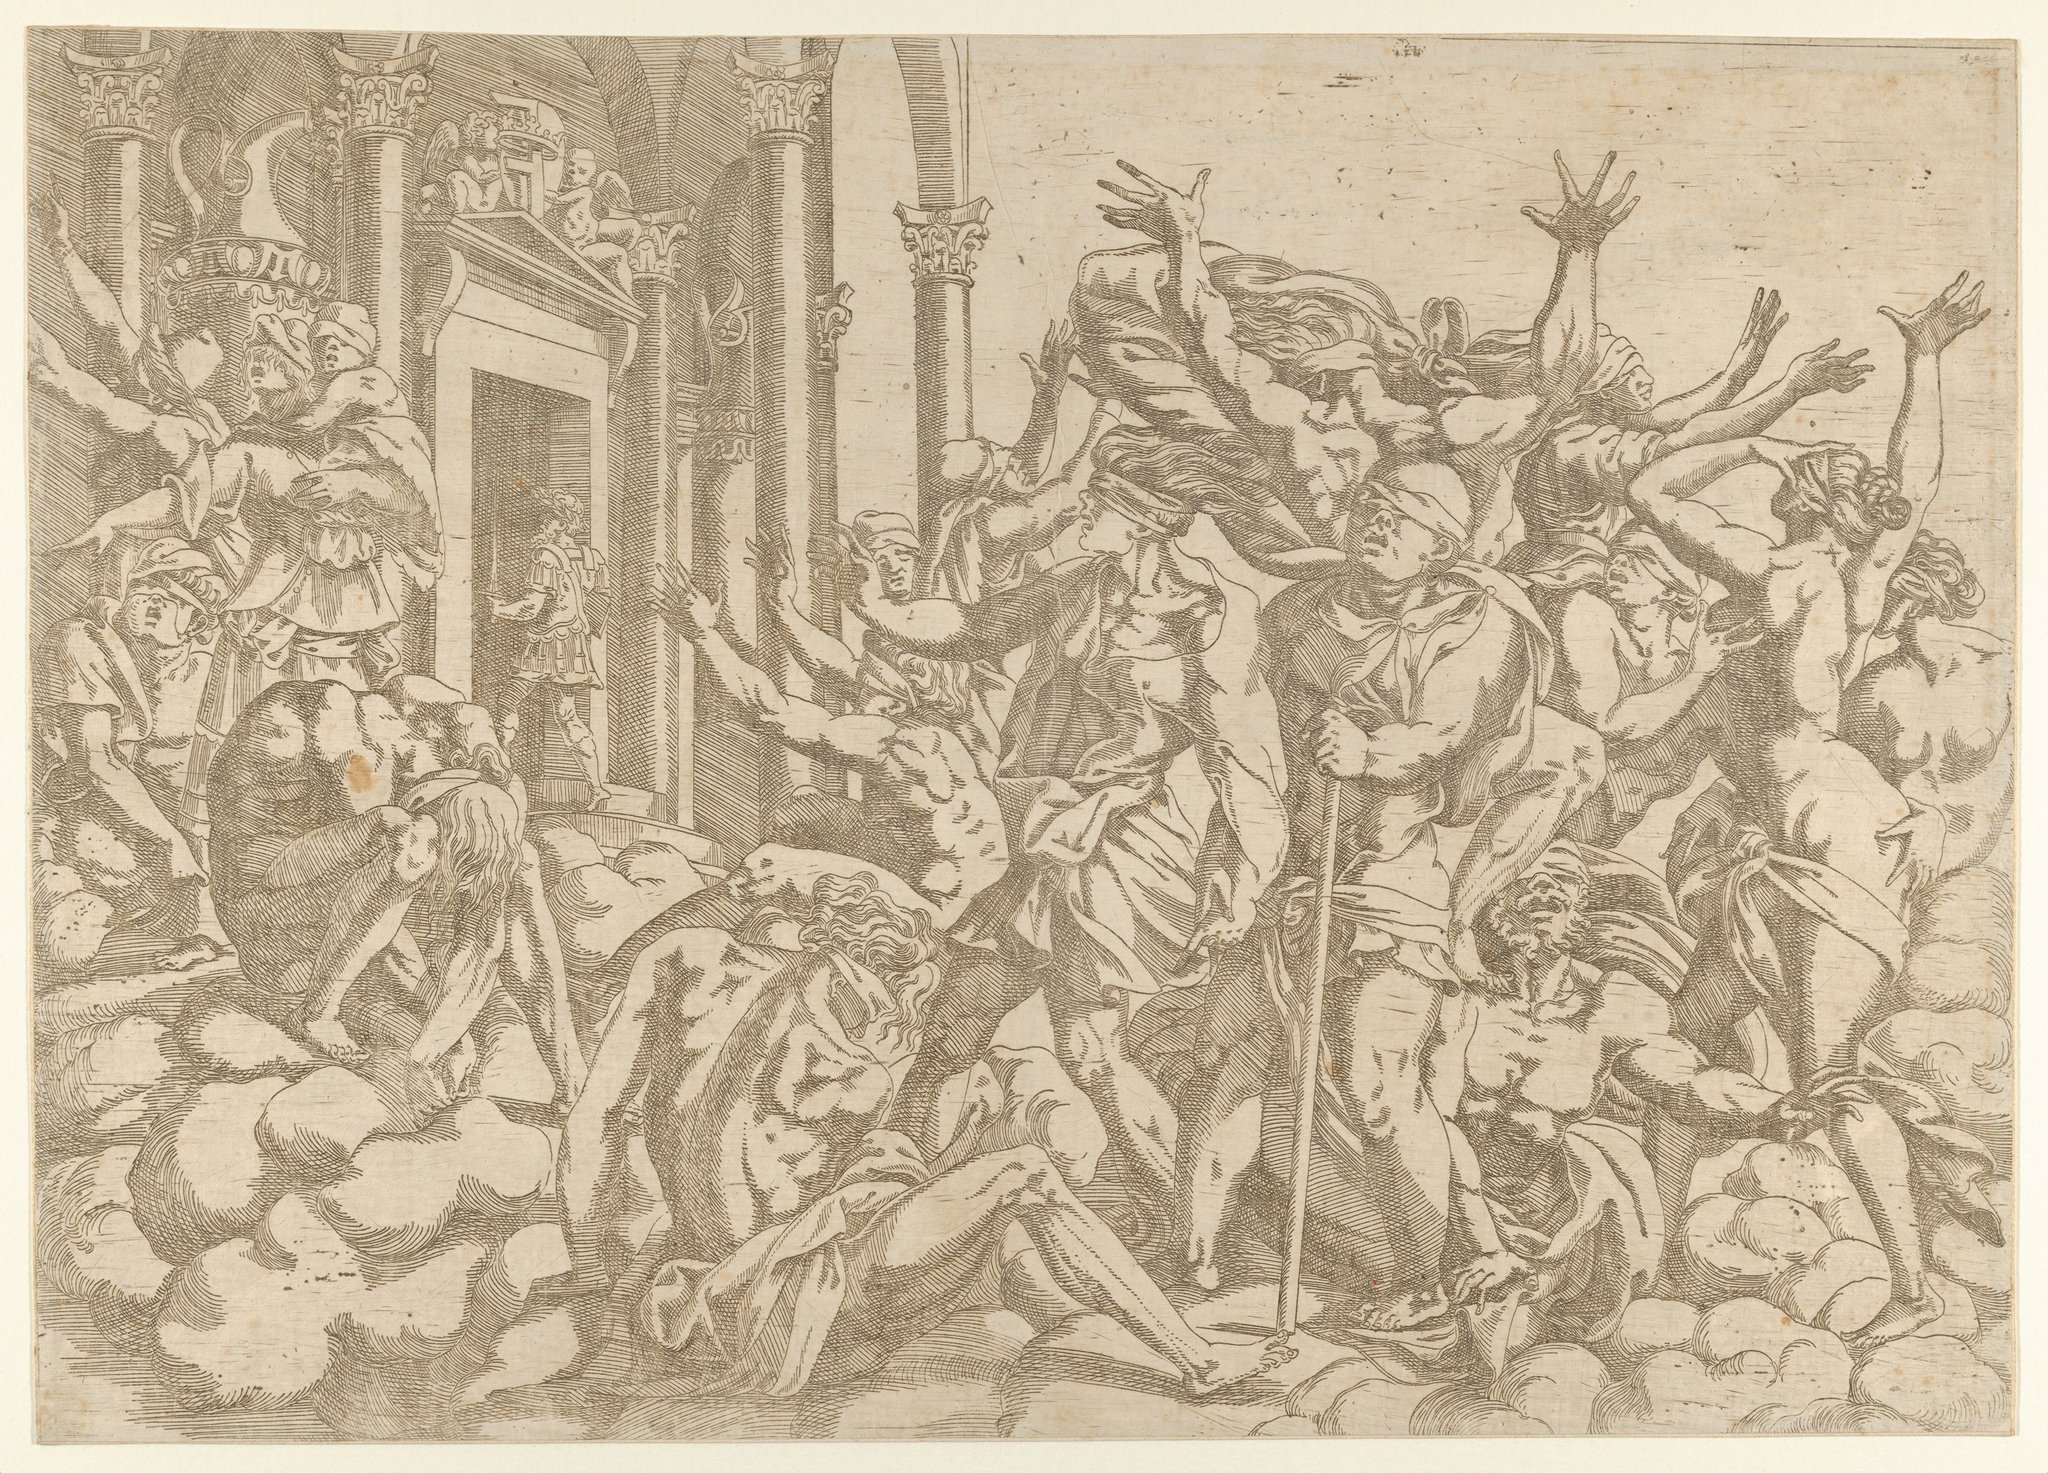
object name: print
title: Ignorance Defeated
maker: antonio fantuzzi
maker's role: artist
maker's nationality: italian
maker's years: 1537-1545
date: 1540-1545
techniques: etching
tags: men,women,crowd